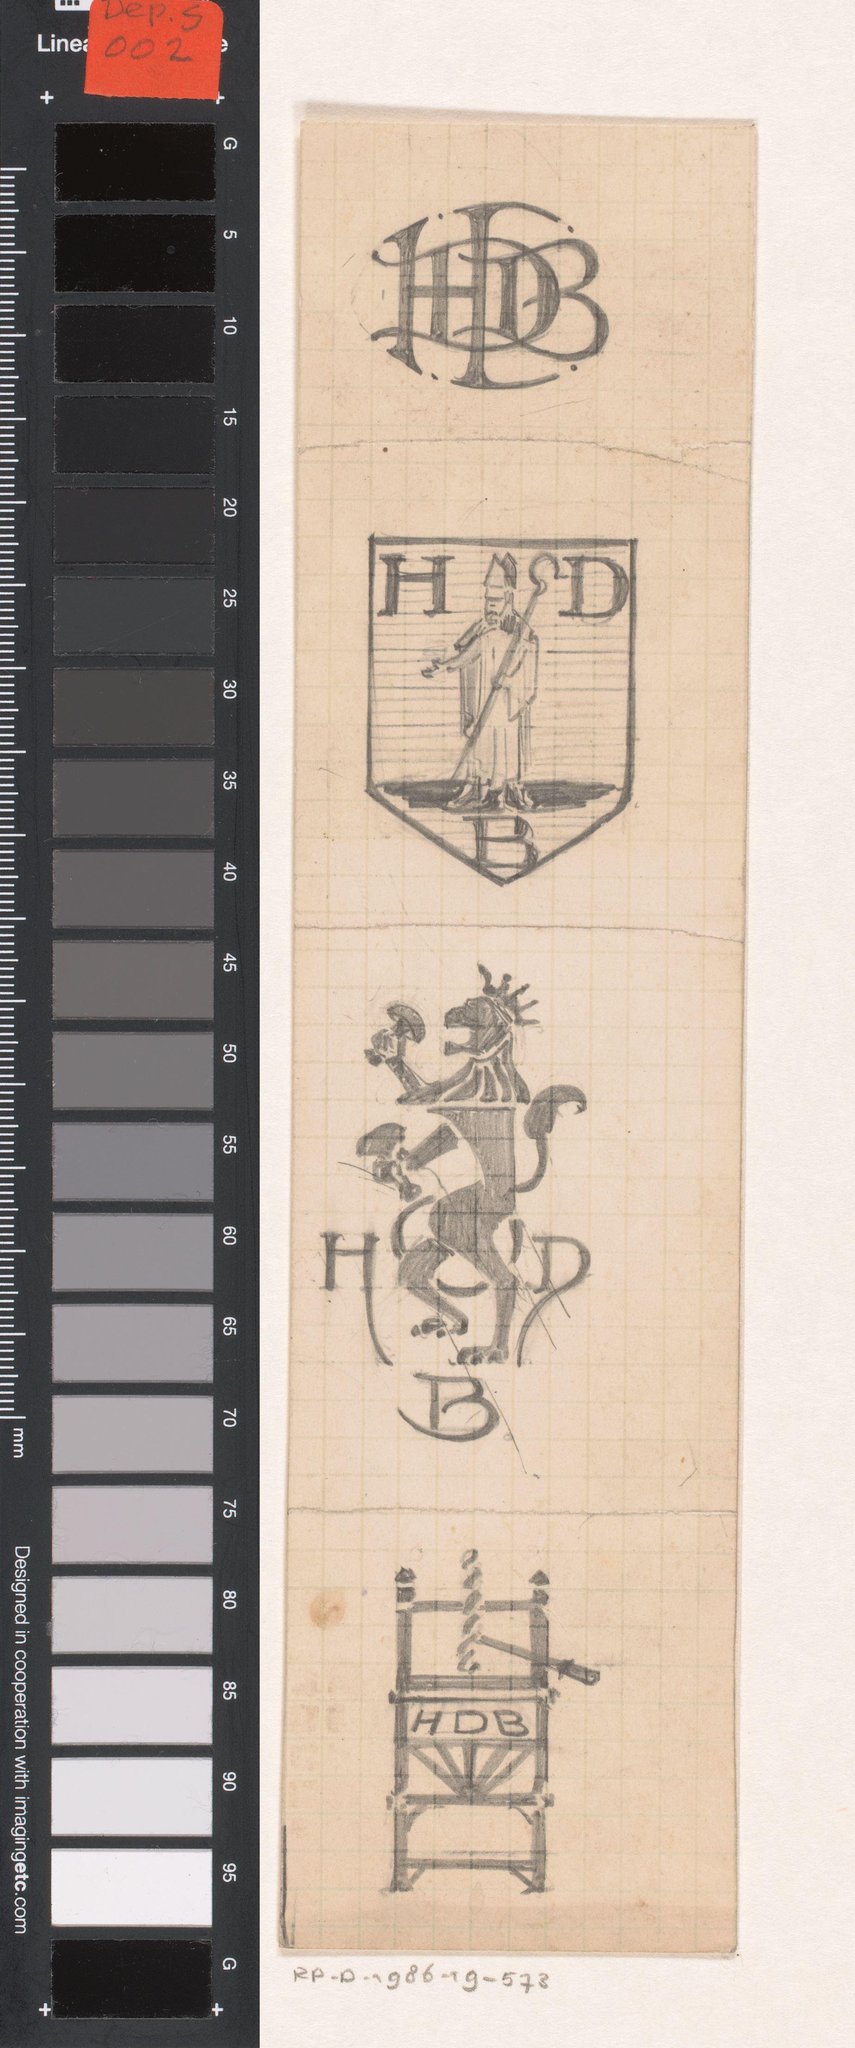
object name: drawing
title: Vier vignetten met de initialen HDB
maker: reinier willem petrus de vries (1874-1953)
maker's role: draughtsman, print maker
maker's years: 1874-1953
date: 1884-1952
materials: pencil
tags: coat of arms (as symbol of the state, etc.), magic mathematical figures; magic numbers, words, monograms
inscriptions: collector's mark: ‘R:MVS.’